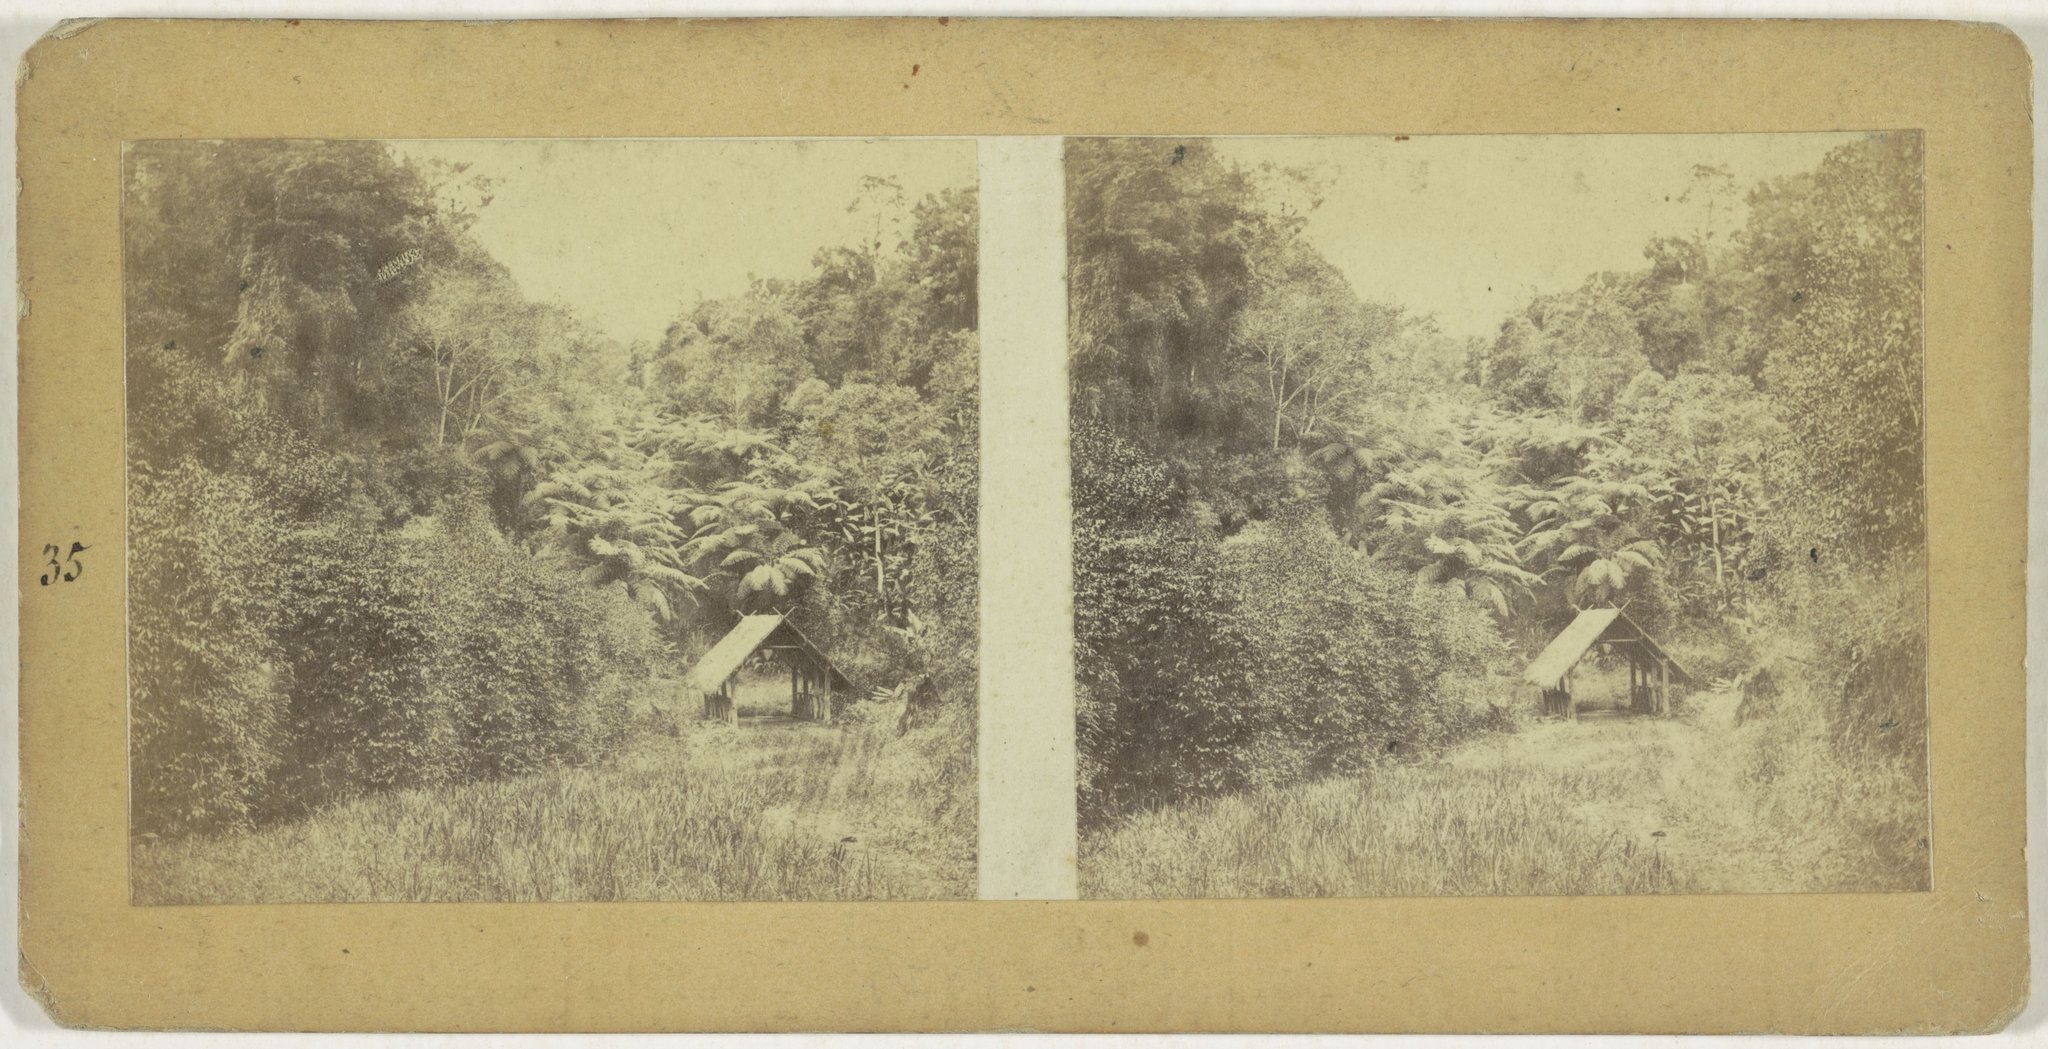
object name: stereograph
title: Bosweg van Tjibeureum naar Cibinong, West-Java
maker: Anonymous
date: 1868-1890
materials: cardboard, paper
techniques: albumen print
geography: west java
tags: road, path, jungle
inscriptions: inscription: ‘Groep boomvarens (Alsophila/ contaminans, Wall.) op den weg/ van Tjibeuroem naar Tjibitoeng./ 4900 voet.’, number: ‘35’